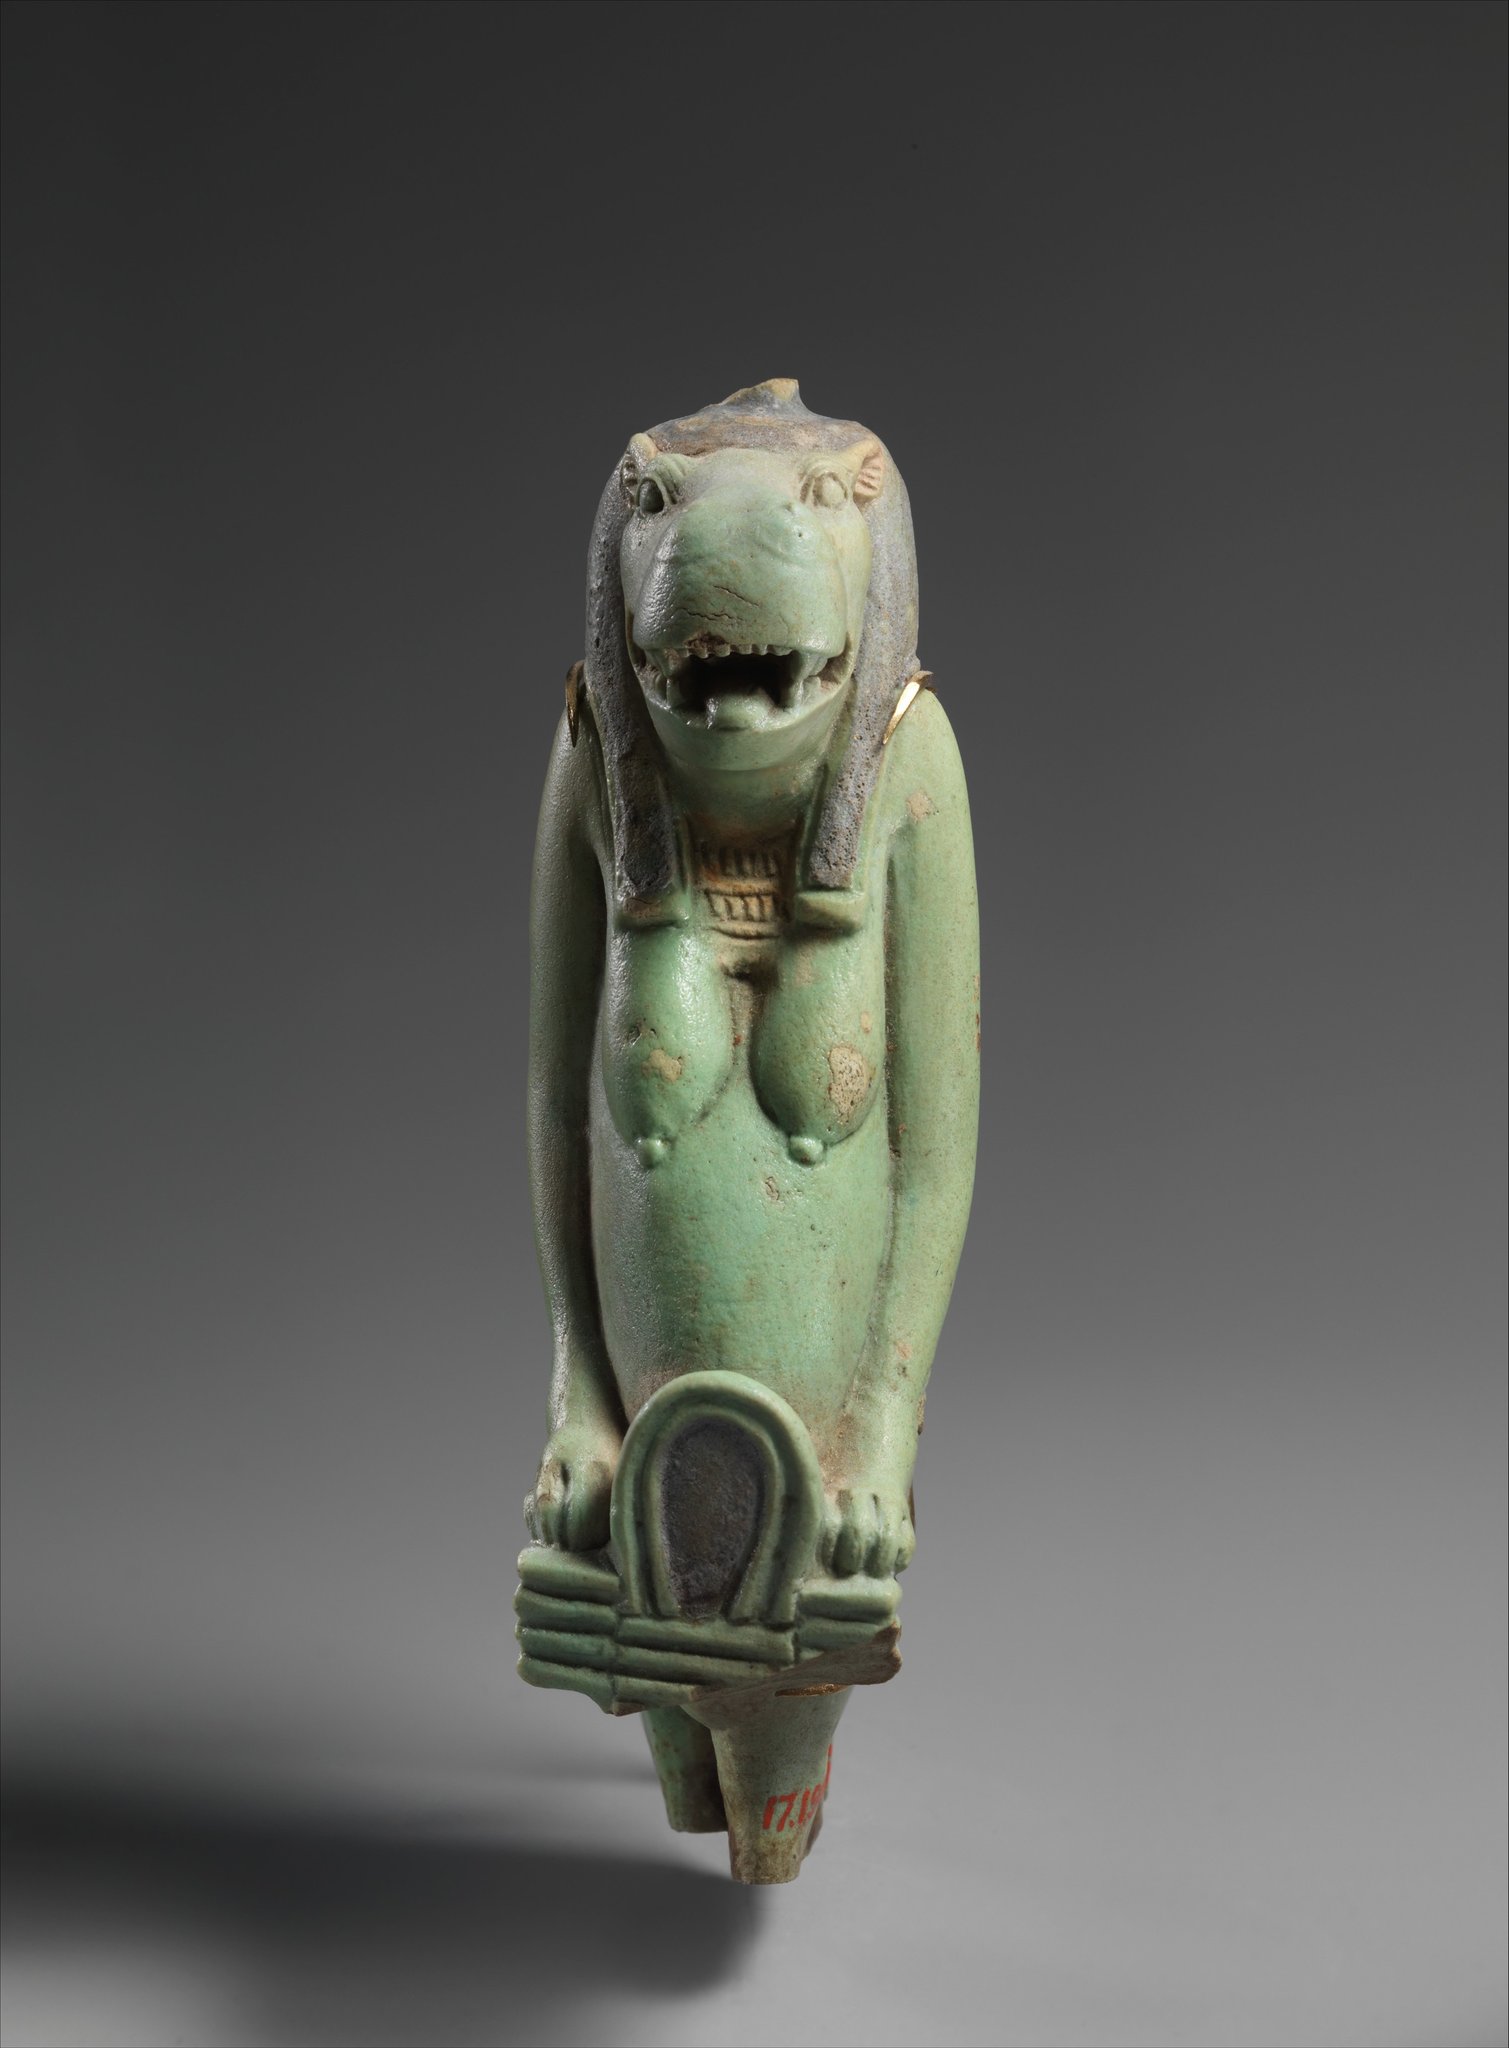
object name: amulet, taweret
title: Amulet of Taweret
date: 664-332 BCE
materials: faience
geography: egypt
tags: taweret